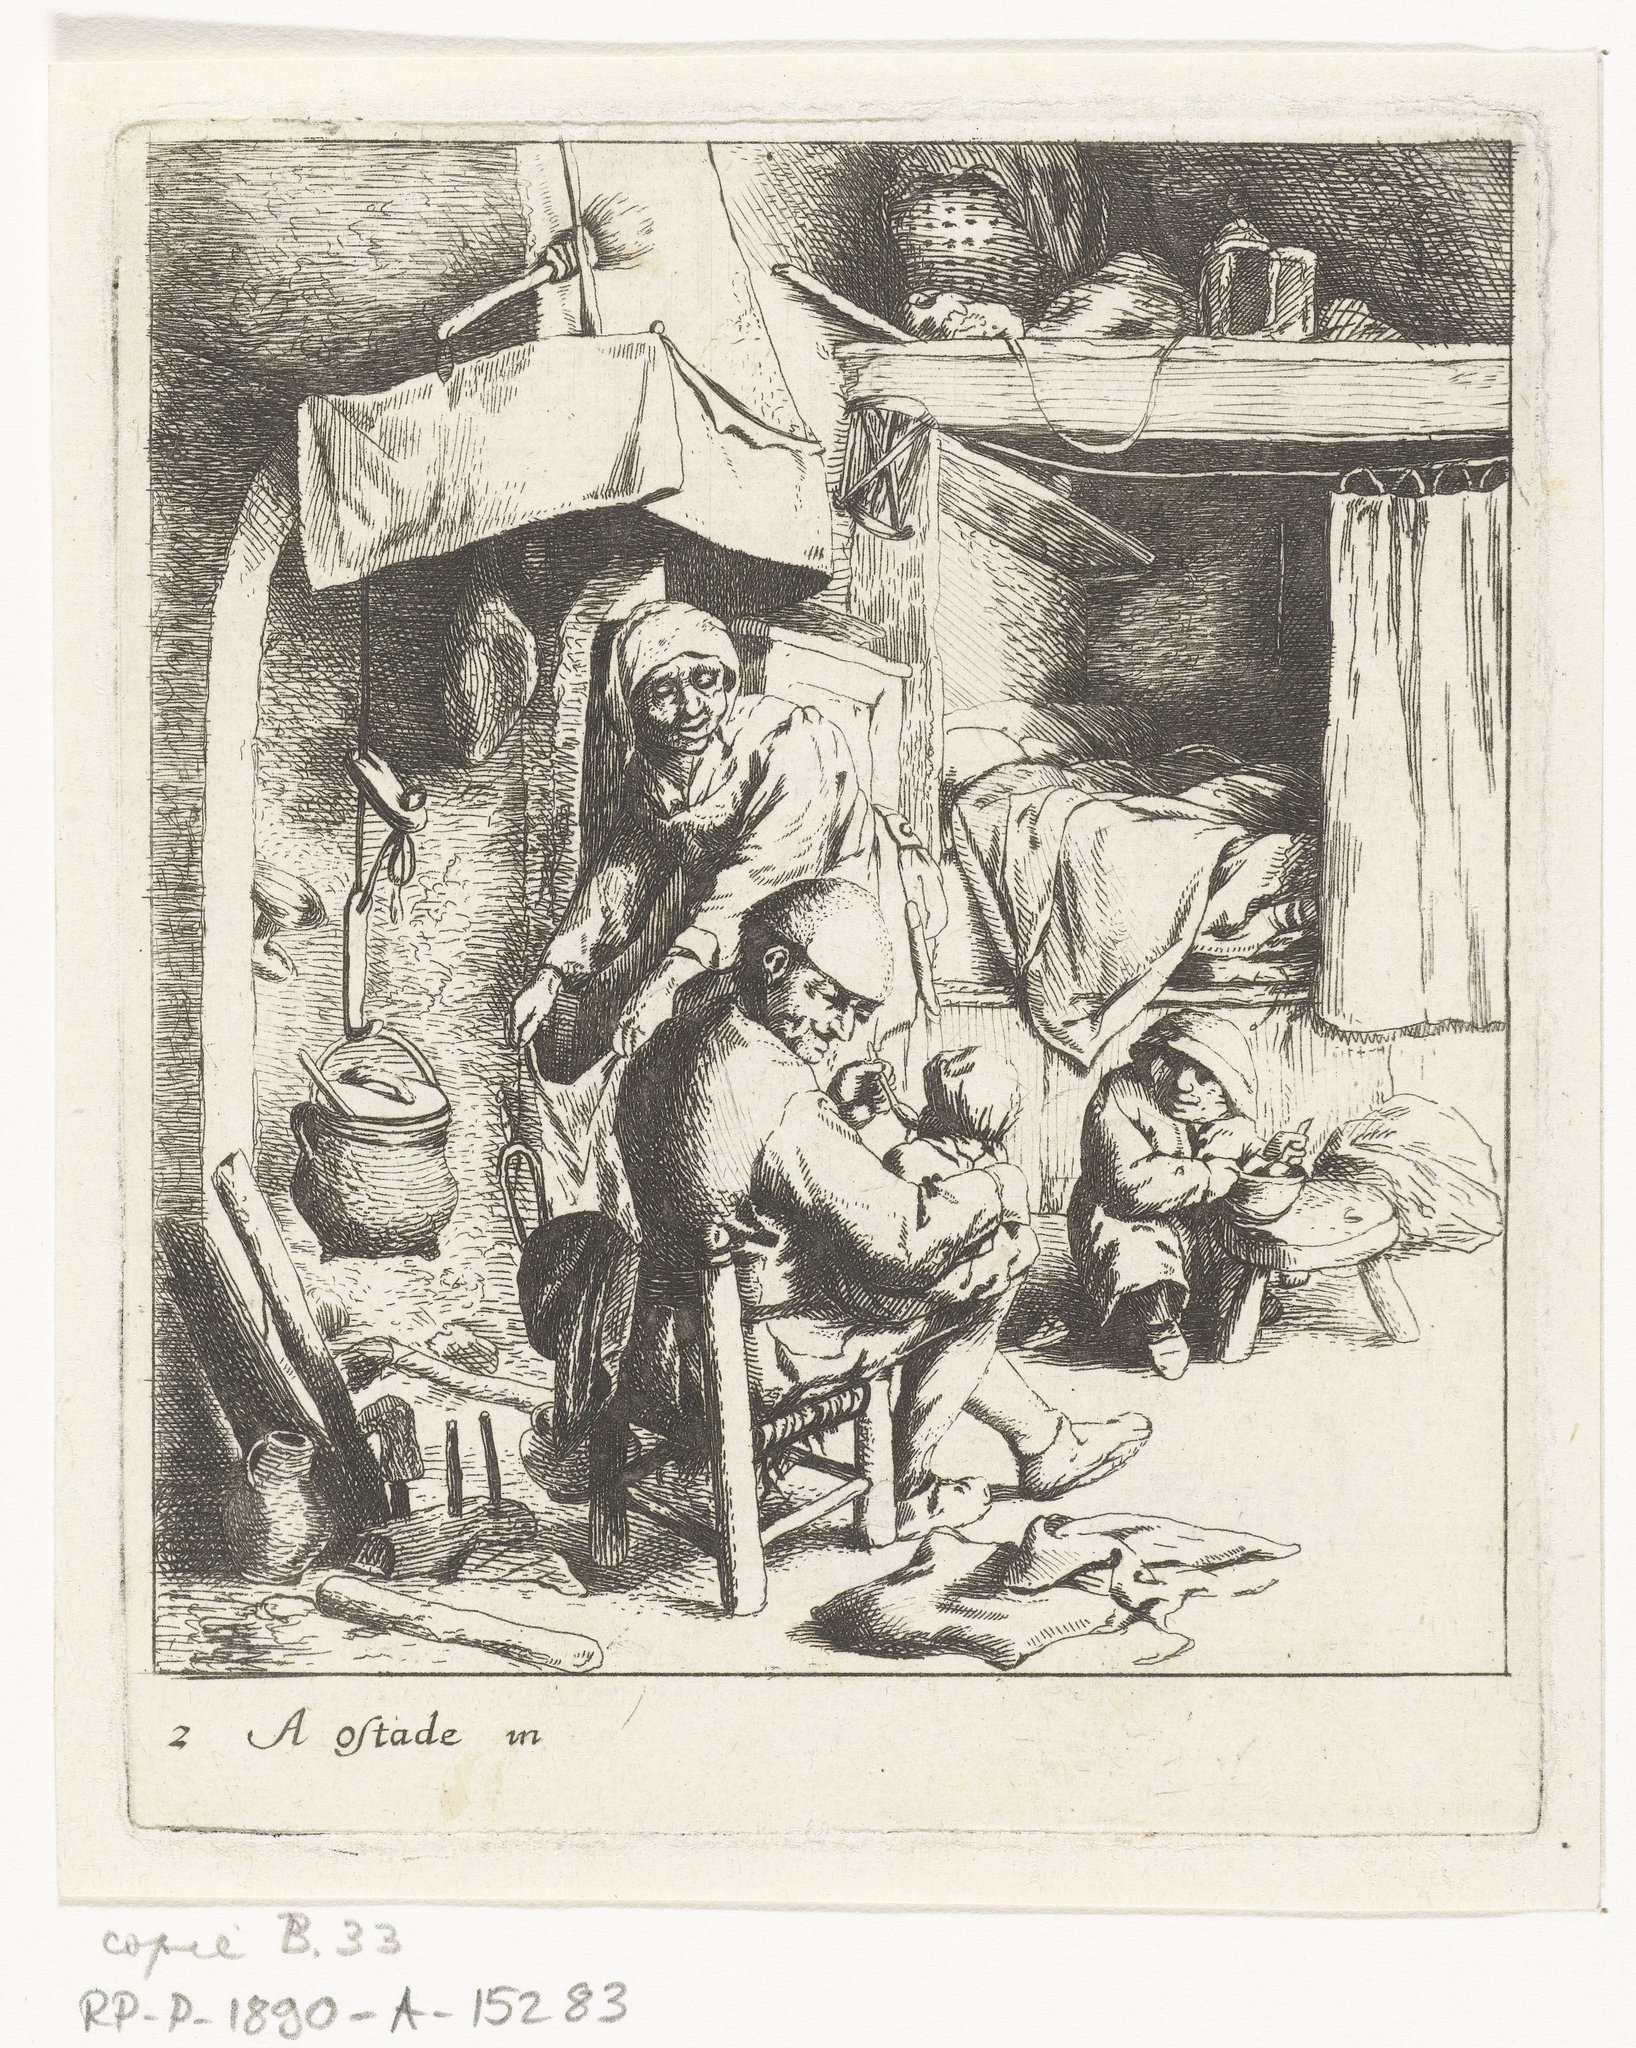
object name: print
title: Vader met kind op schoot in interieur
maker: abraham bloteling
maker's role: draughtsman, print maker, publisher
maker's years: 1640-1690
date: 1655-1690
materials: paper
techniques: etching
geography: amsterdam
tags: open hearth, fire-place, feeding a baby, father-love, father and child(ren), man and child(ren) (family group), built-in bedstead (dutch: 'bedstee')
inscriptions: collector's mark: Lugt 2228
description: Een vader geeft een klein kind op zijn schoot te eten, de moeder staat bij de haard waar een pot boven het vuur hangt. Een klein kind zit op de grond bij een kruk te eten. Dit boeren gezin is gesitueerd in een armoedig interieur met verschillende huishoudelijke attributen en op de achtergrond een bedstee. Prent uit een serie van acht prenten naar voorstellingen van A. van Ostade.